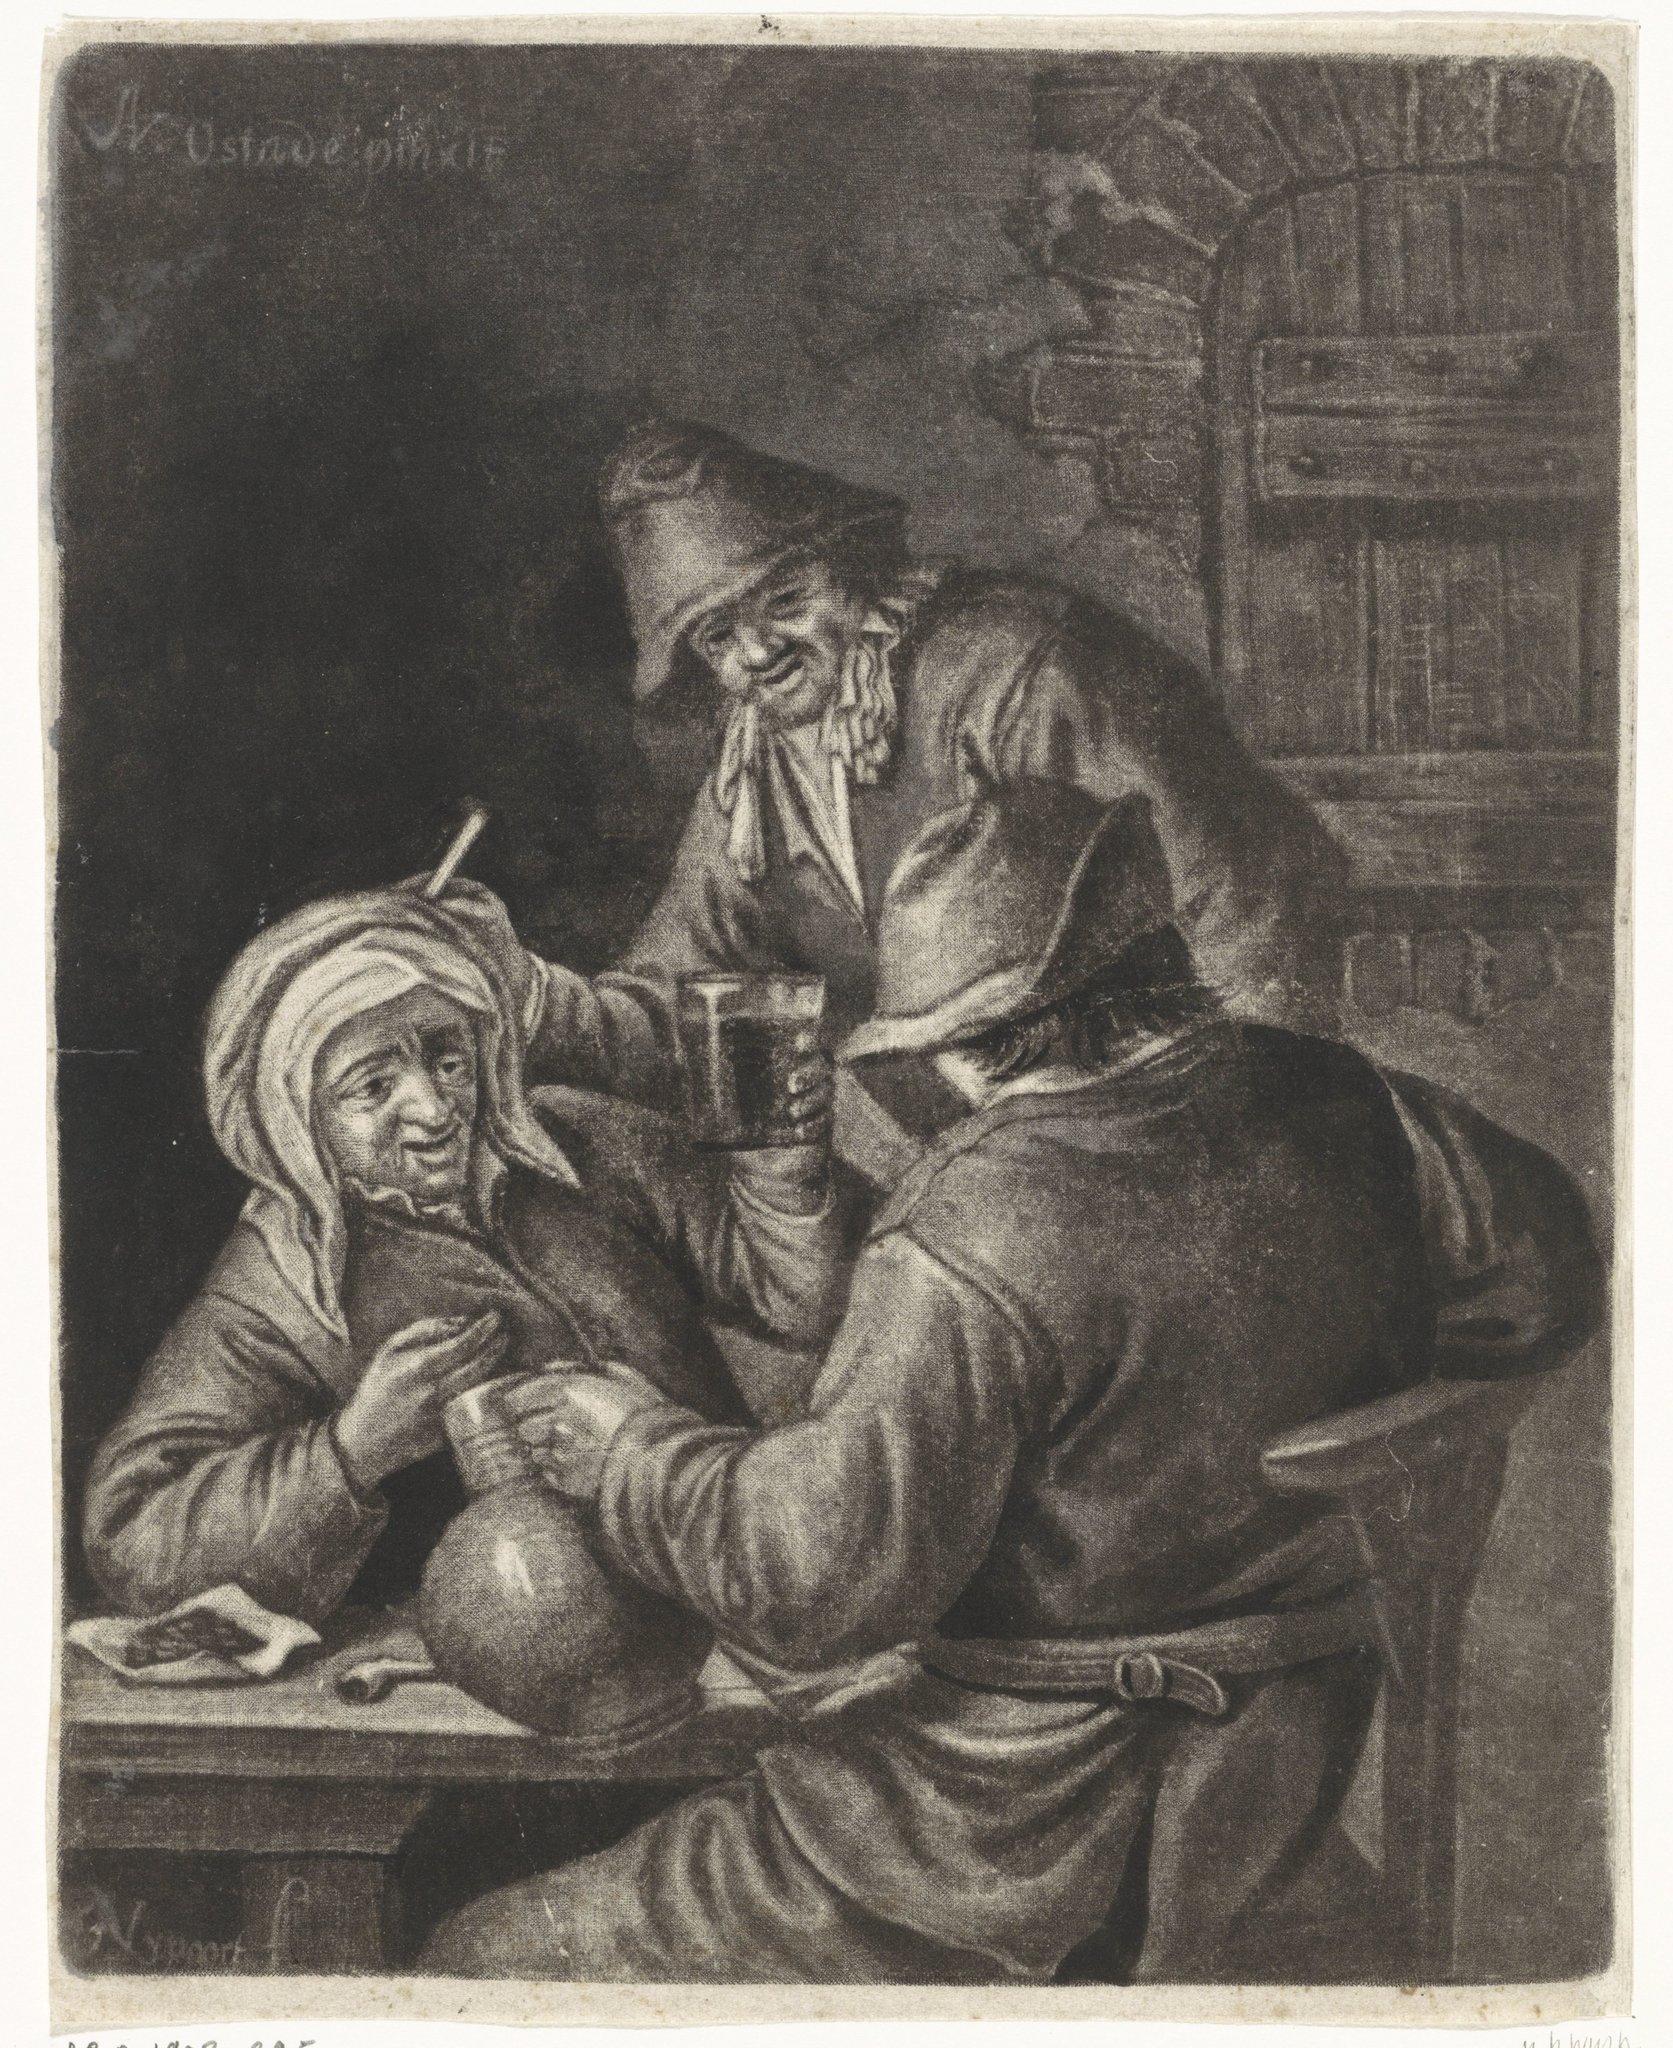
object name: print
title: Drie drinkende figuren in een herberg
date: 1680-1691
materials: paper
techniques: mezzotint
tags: inn, coffee-house, public house, etc., pipe ~ tobacco, drinking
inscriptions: collector's mark: Lugt 2228, :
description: In een herberg zitten een man en een vrouw te drinken aan een tafel, waarop tabak en een pijp liggen. Een derde figuur loopt pijprokend langs hen.